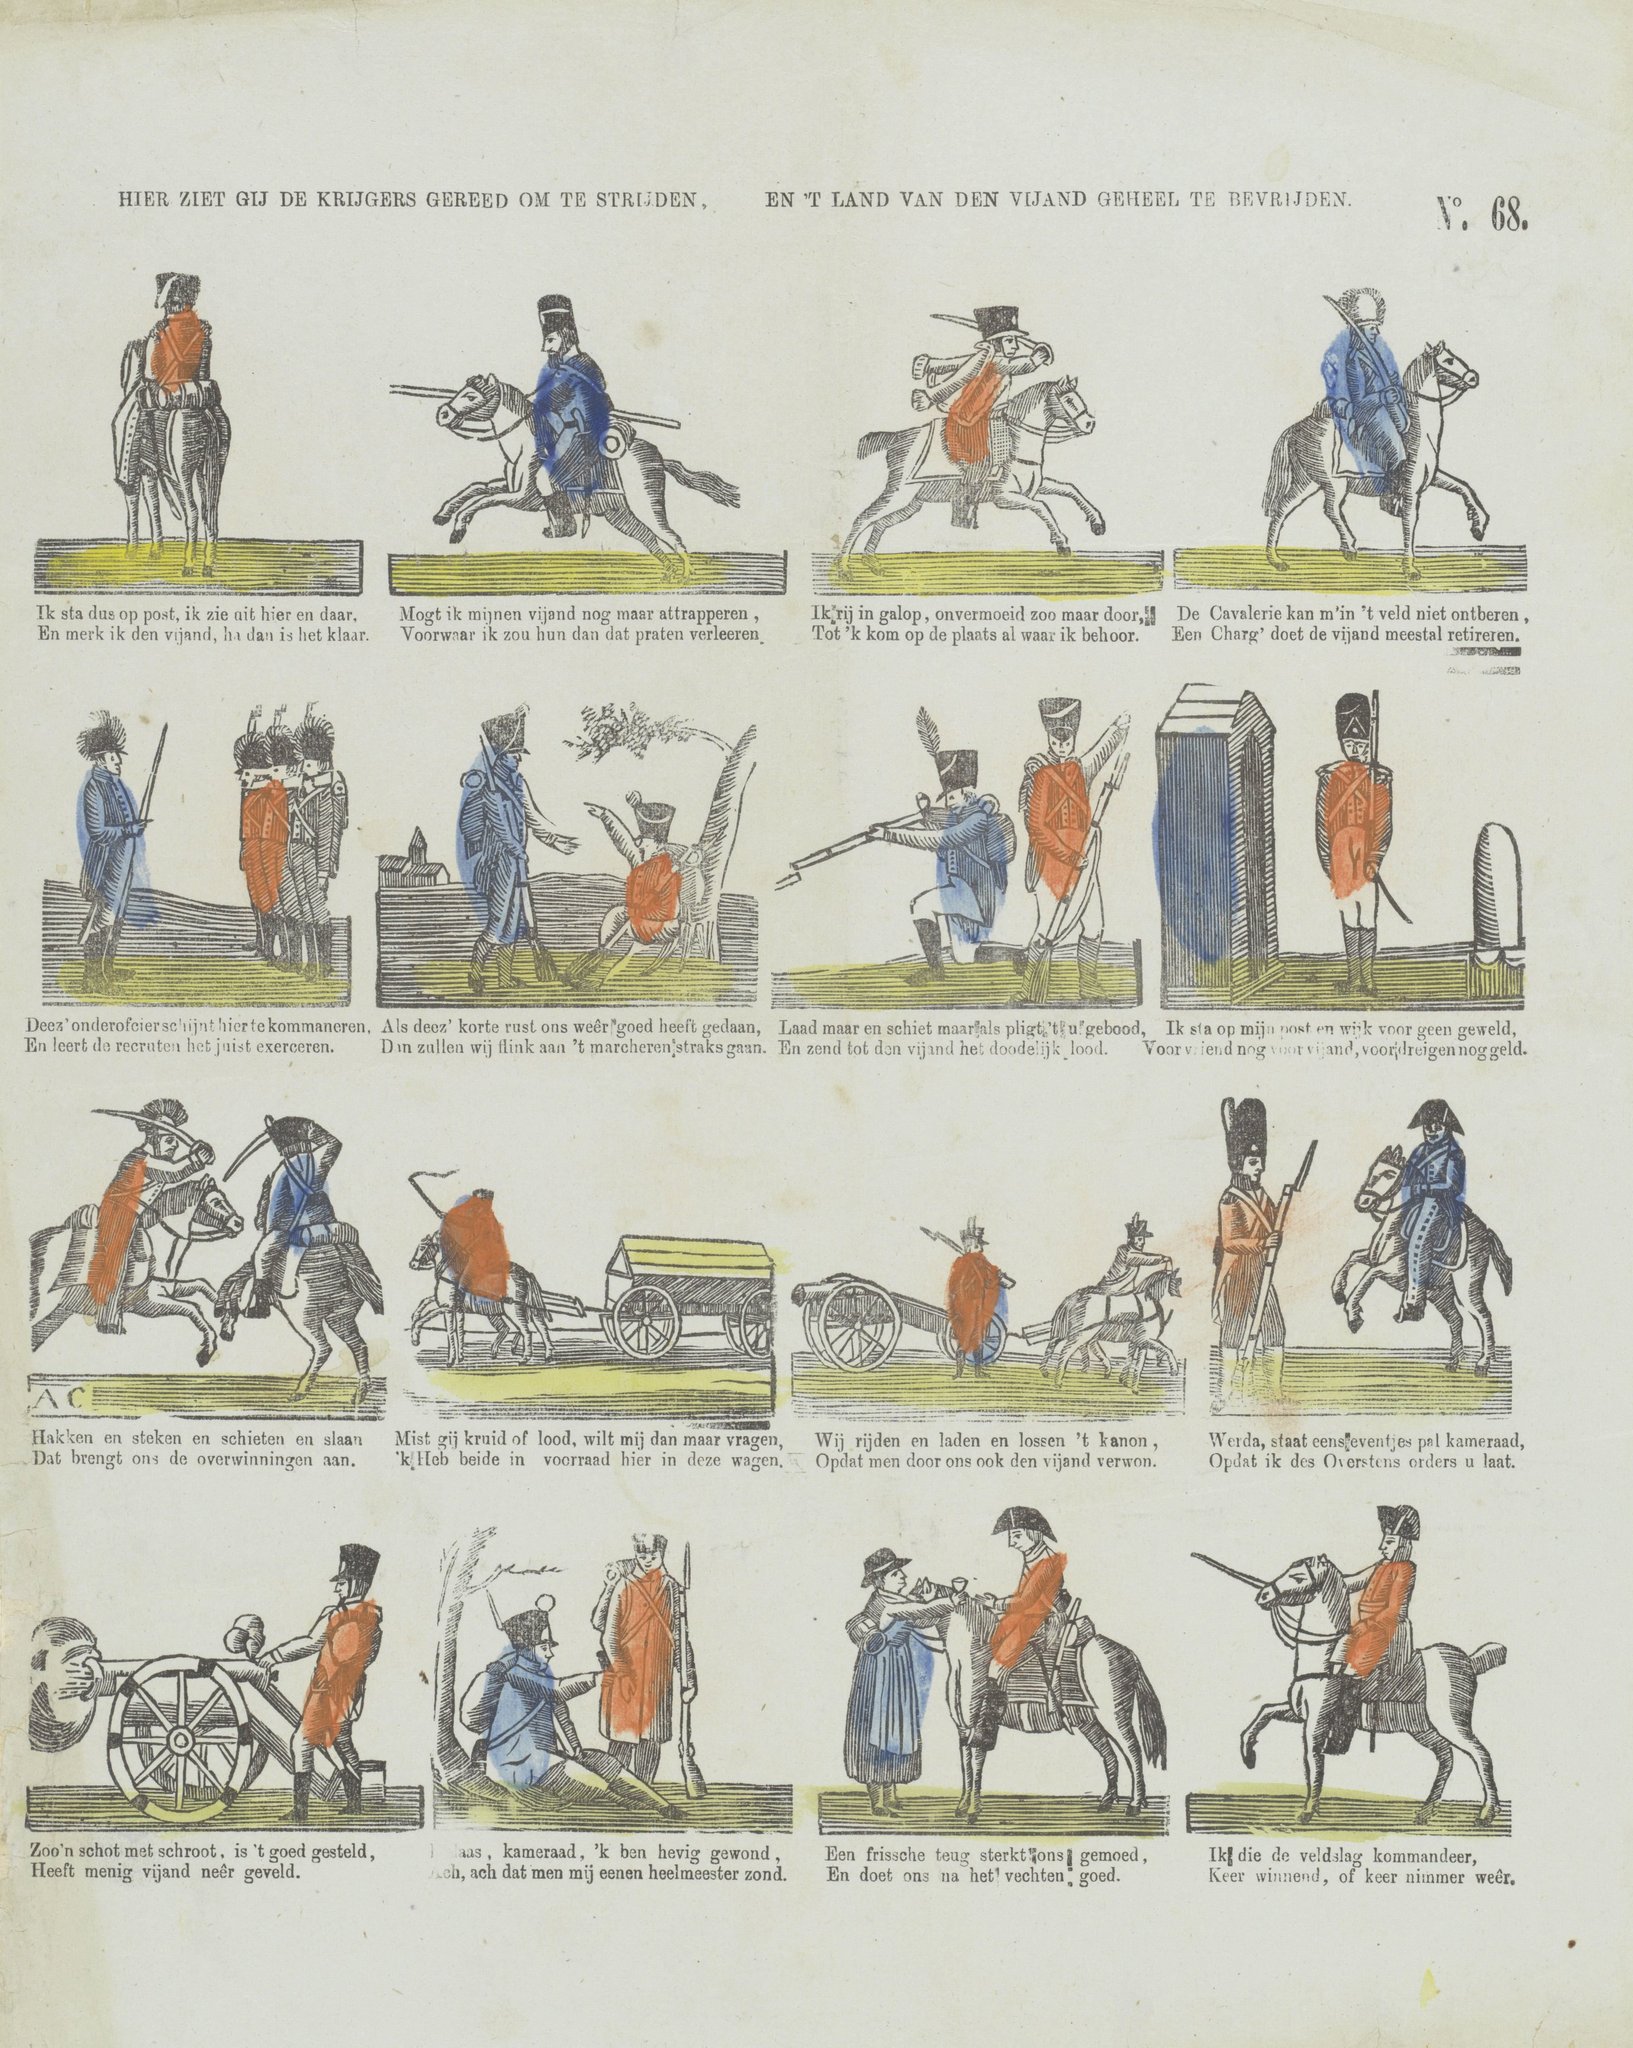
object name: print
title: Hier ziet gij de krijgers gereed om te strijden / En 't land van den vijand geheel te bevrijden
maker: alexander cranendoncq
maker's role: draughtsman, print maker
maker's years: 1799-1869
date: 1850-1870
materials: paper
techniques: colour, letterpress printing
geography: netherlands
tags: firearms: cannon (+ handling of weapons), warfare; military affairs (+ cavalry, horsemen), the soldier; the soldier's life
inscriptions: collector's mark: Lugt 2760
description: Blad met 16 voorstellingen van militairen. Onder elke afbeelding een tweeregelig vers. Genummerd rechtsboven: No. 68.